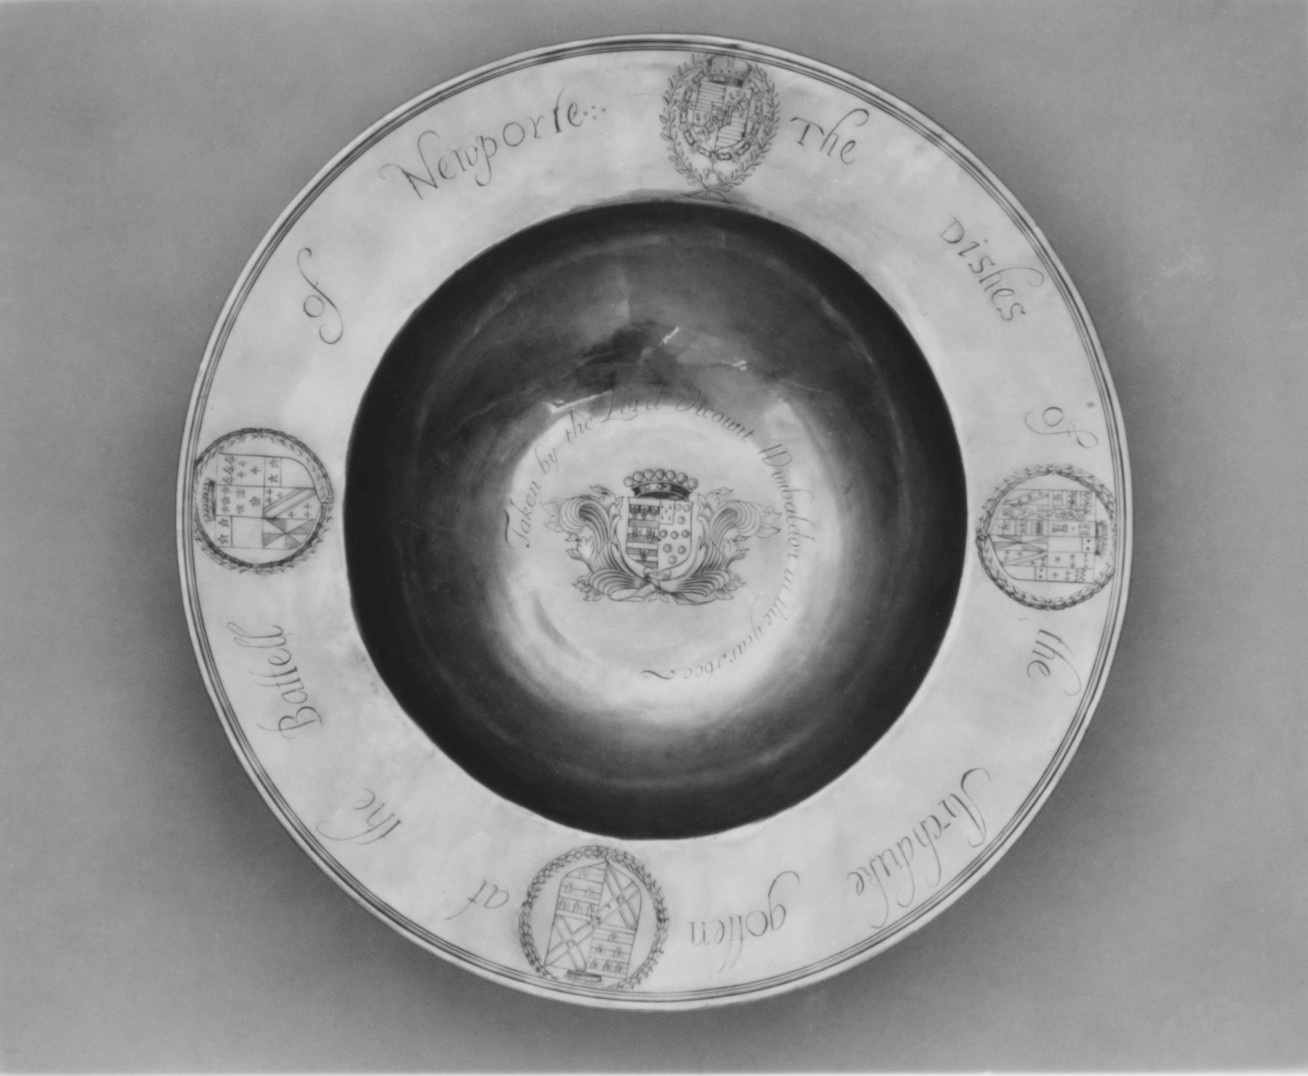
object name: dish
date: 1616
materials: silver gilt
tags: coat of arms